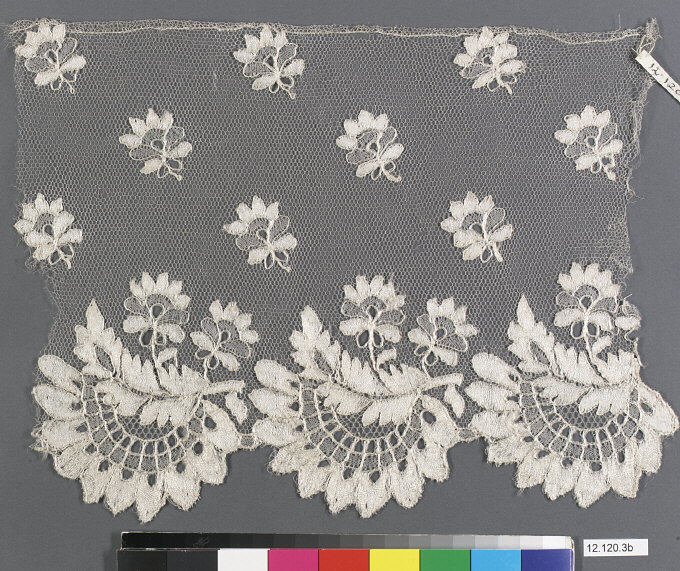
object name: flounce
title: Flounce (part of a wedding veil)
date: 1801-1900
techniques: lace